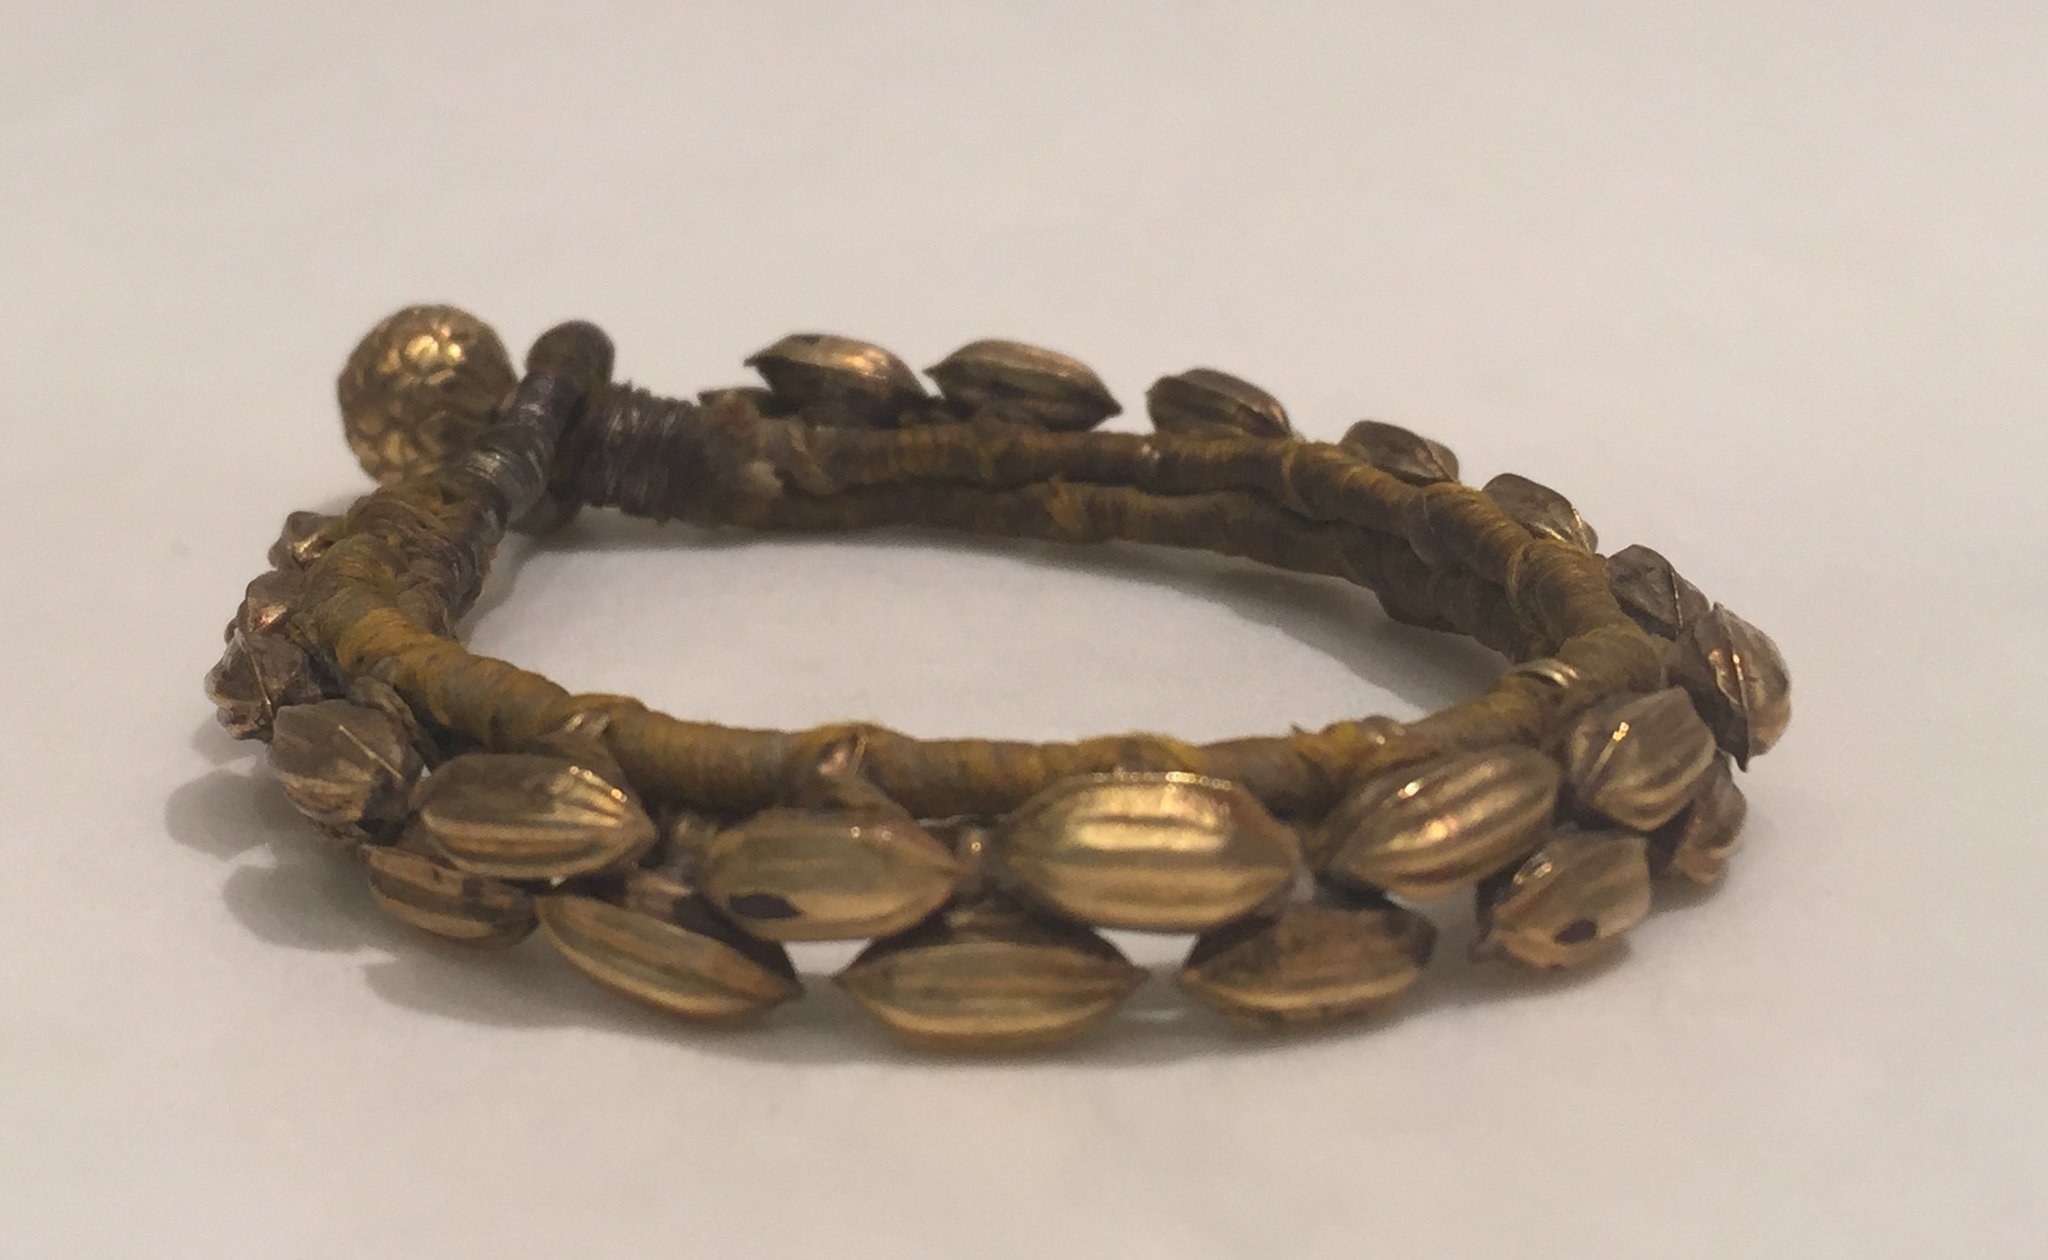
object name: bracelet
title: Bracelet with Seed Shaped Beads (Pahunchi), One of a Pair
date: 1801-1900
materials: gold, silk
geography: northern india